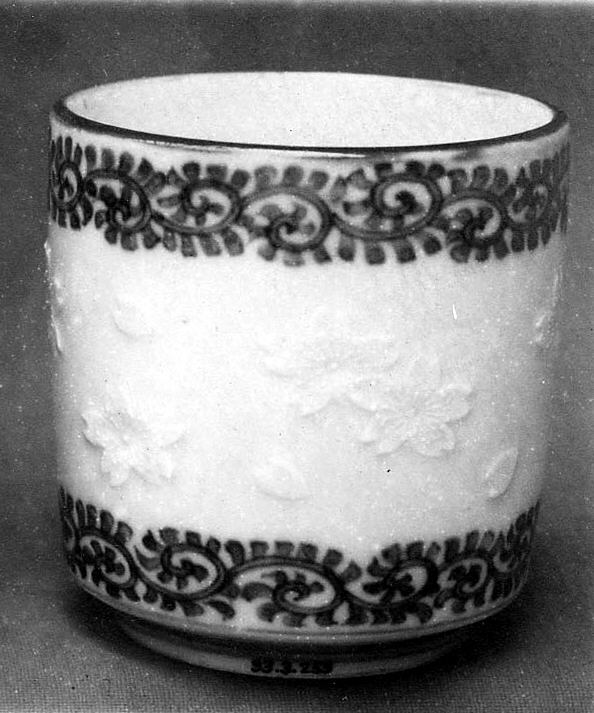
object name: cup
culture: japanese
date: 1780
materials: glaze, porcelain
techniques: relief